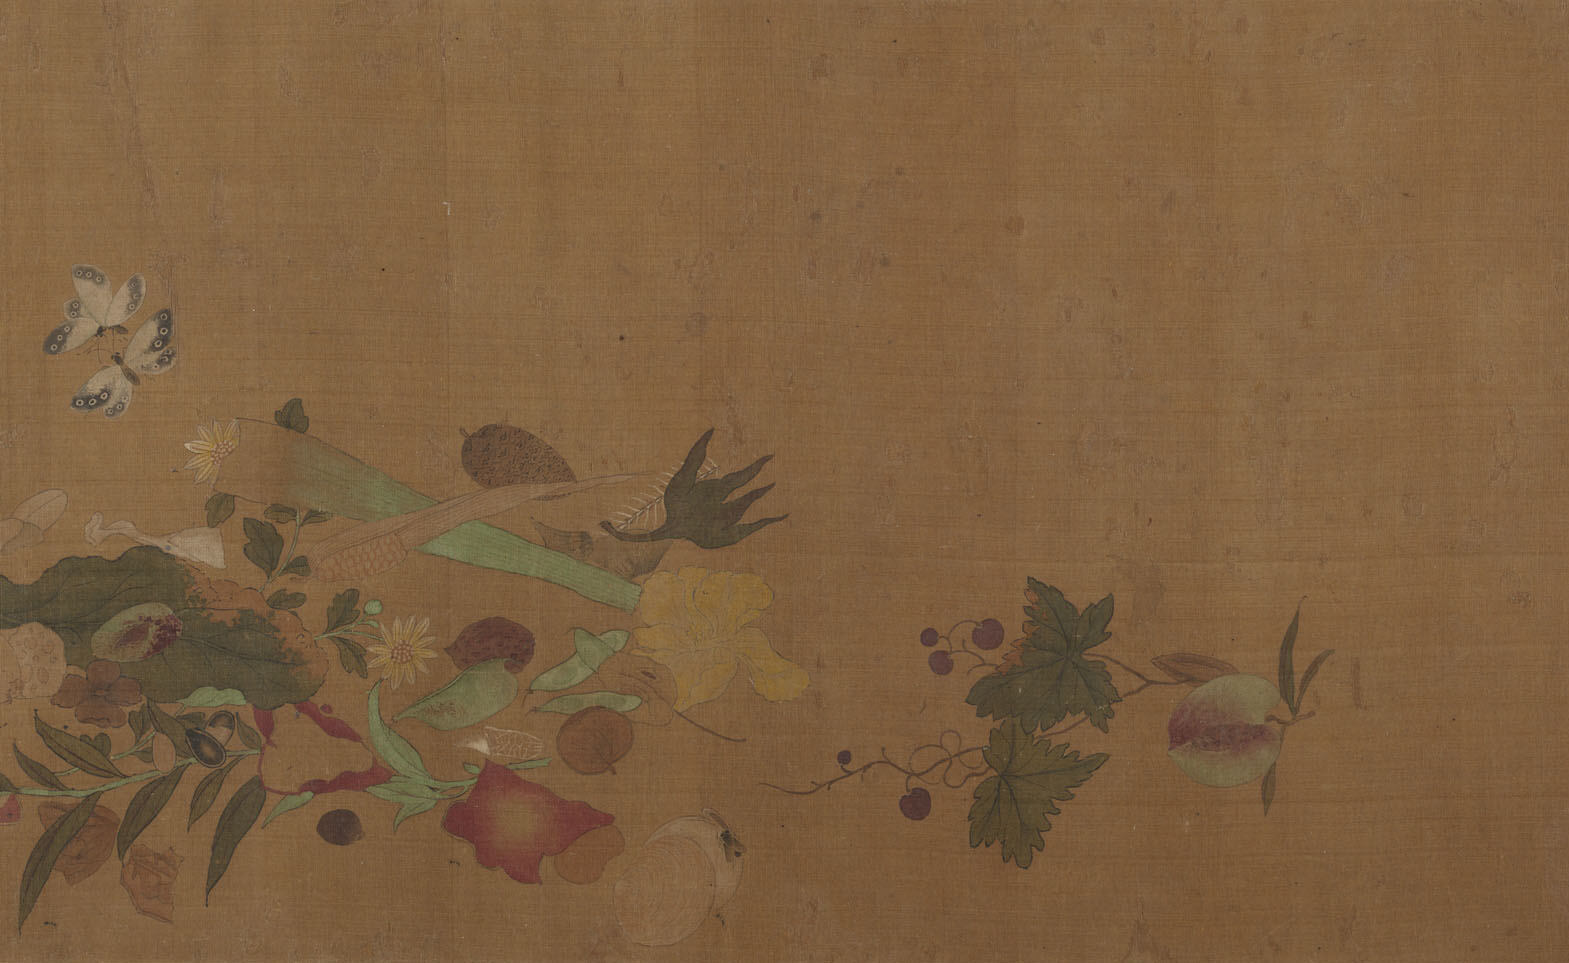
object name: handscroll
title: Flowers and Insects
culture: chinese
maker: unidentified artist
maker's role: artist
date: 1644-1911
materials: ink, silk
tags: butterflies,flowers